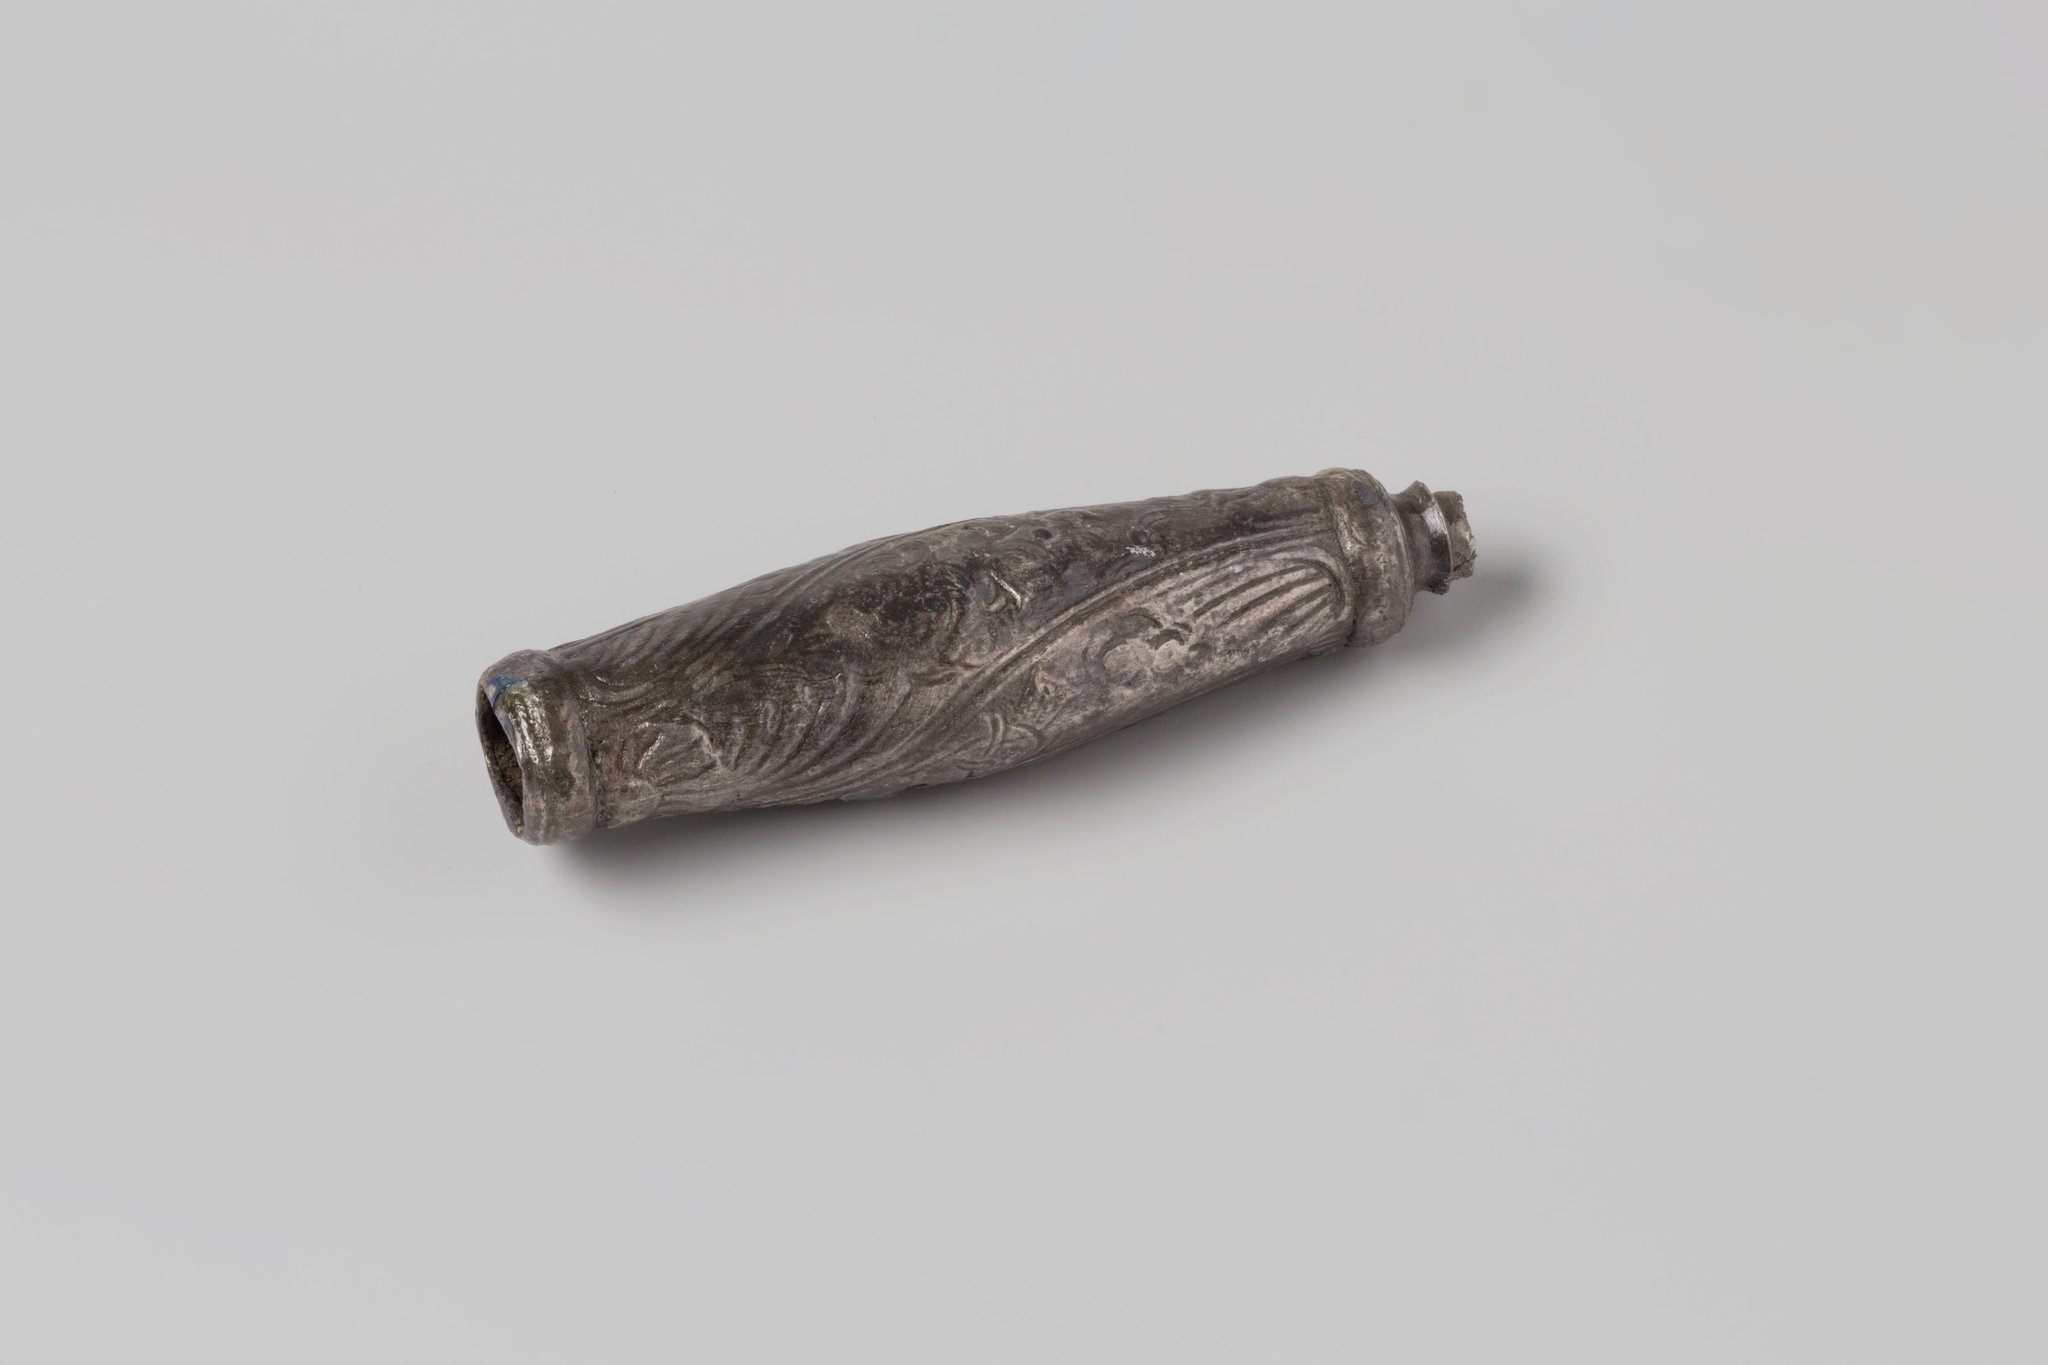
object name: greep gevest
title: Greep van een gevest uit het wrak van de Oost-Indiëvaarder Hollandia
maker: Anonymous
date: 1700-1743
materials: silver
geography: netherlands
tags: verenigde oostindische compagnie, hollandia (schip), annet